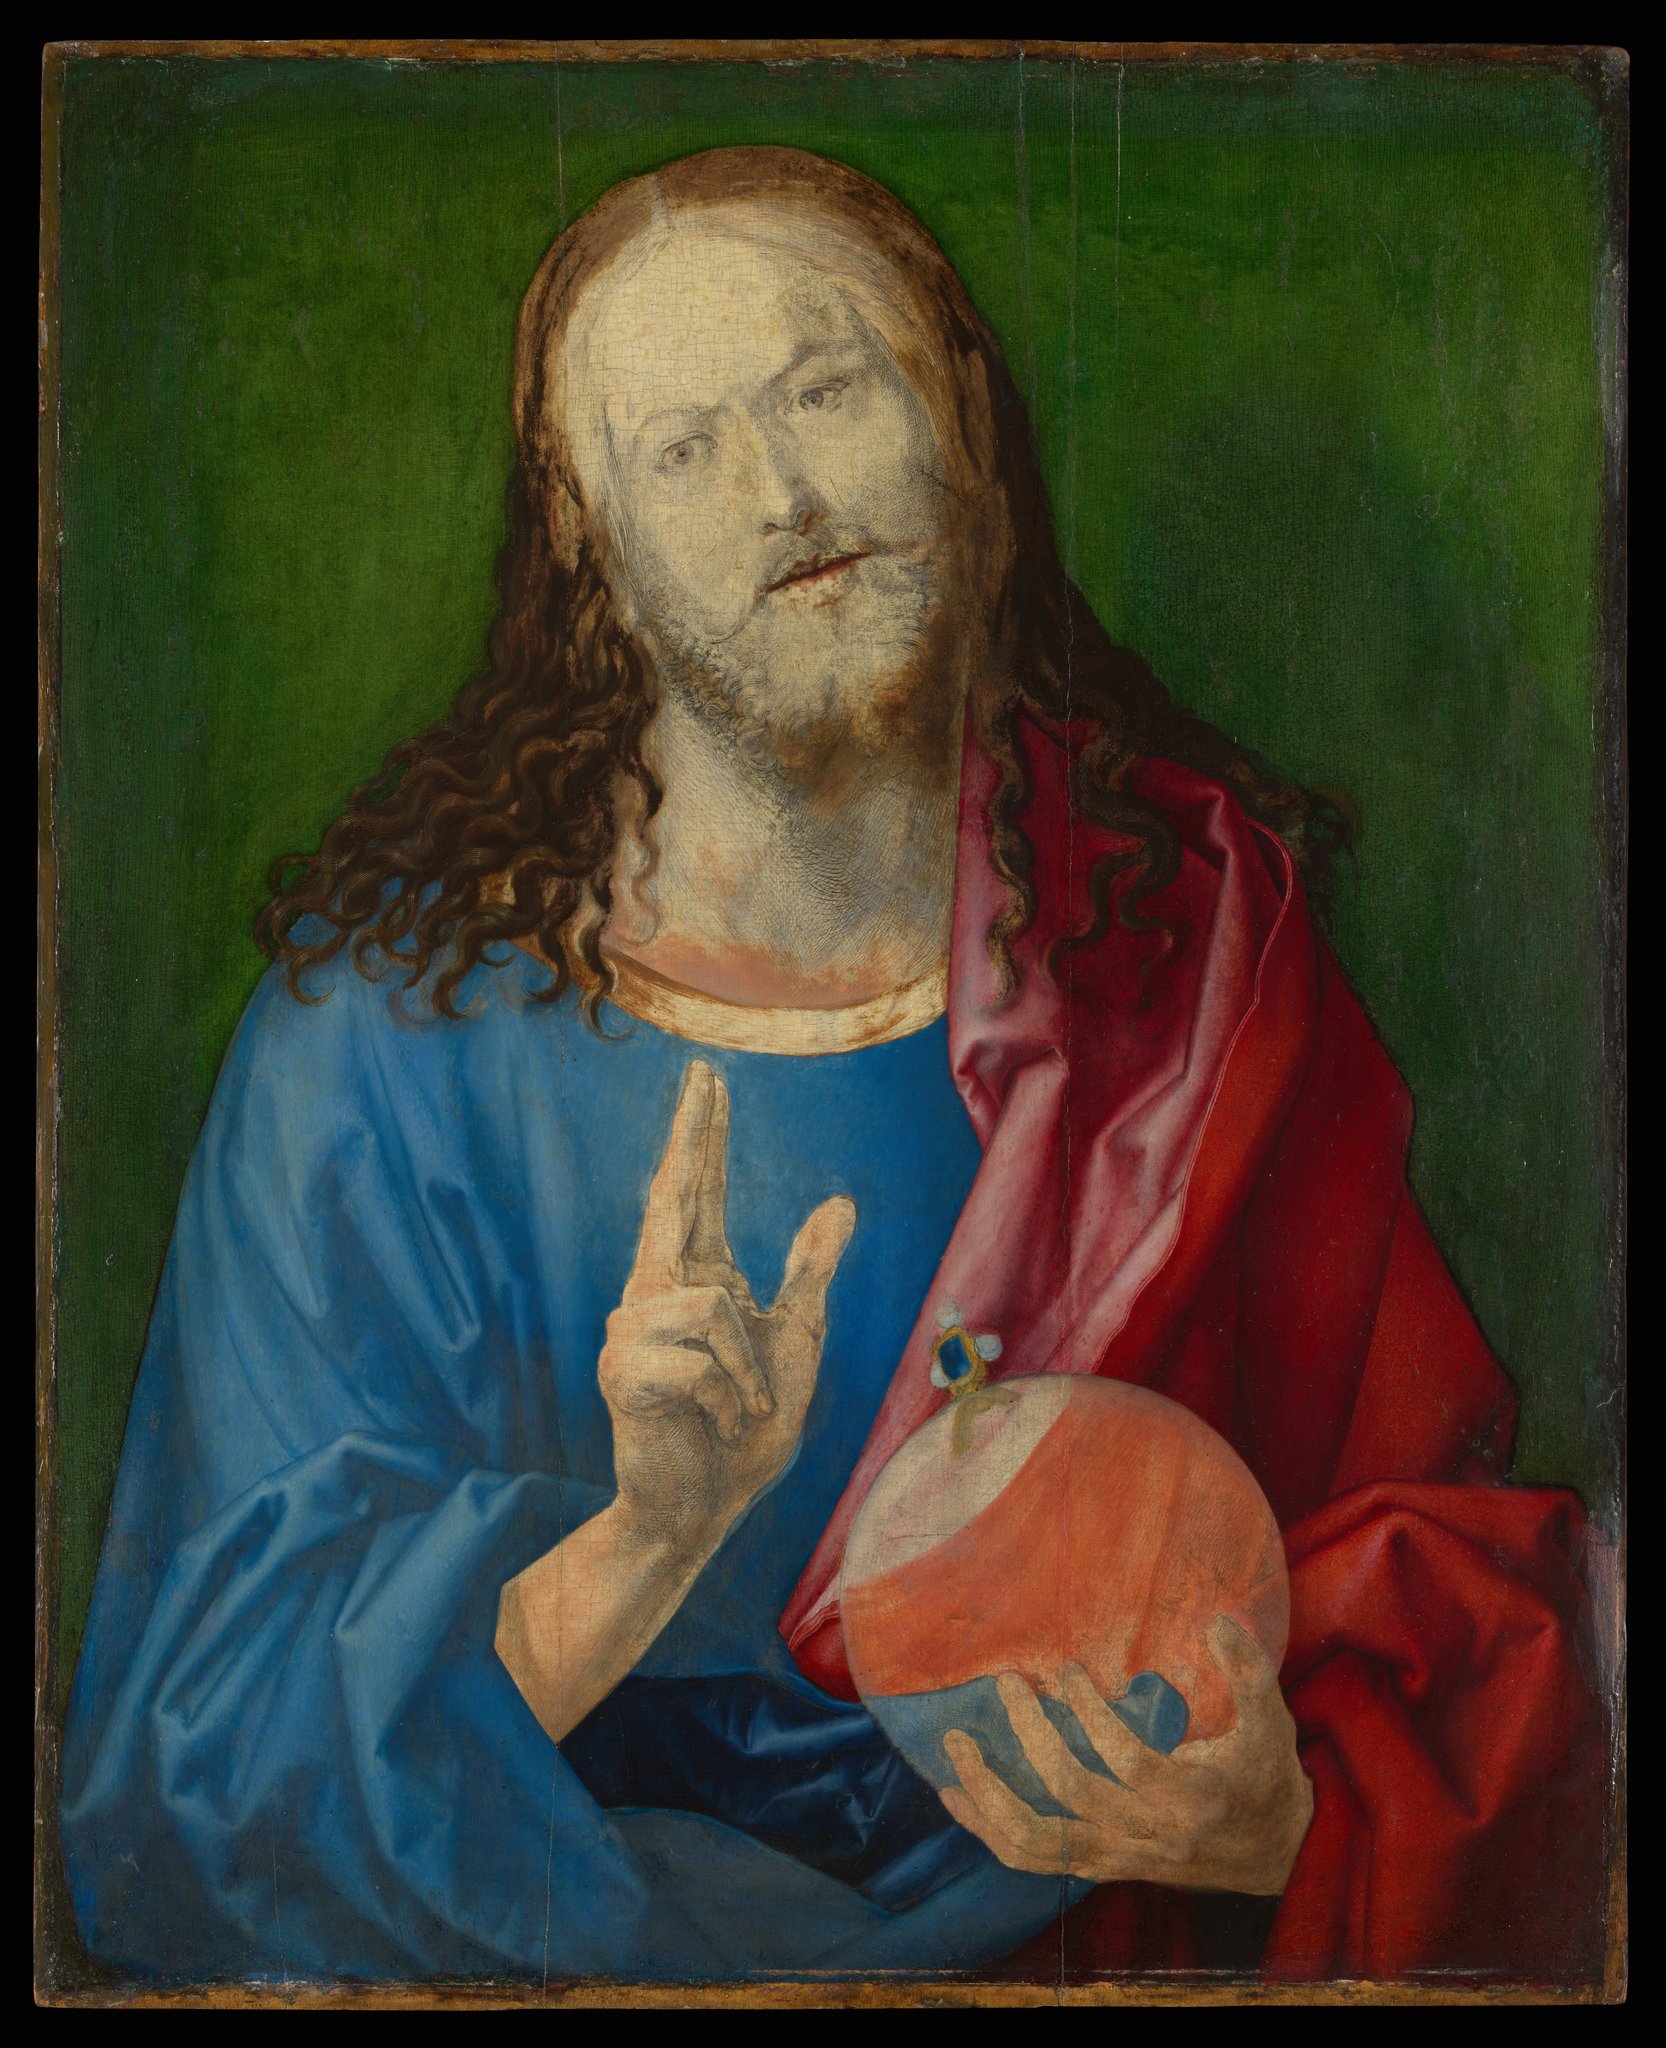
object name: painting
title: Salvator Mundi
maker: albrecht dürer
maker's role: artist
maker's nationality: german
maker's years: 1471-1528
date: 1505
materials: wood, oil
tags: christ